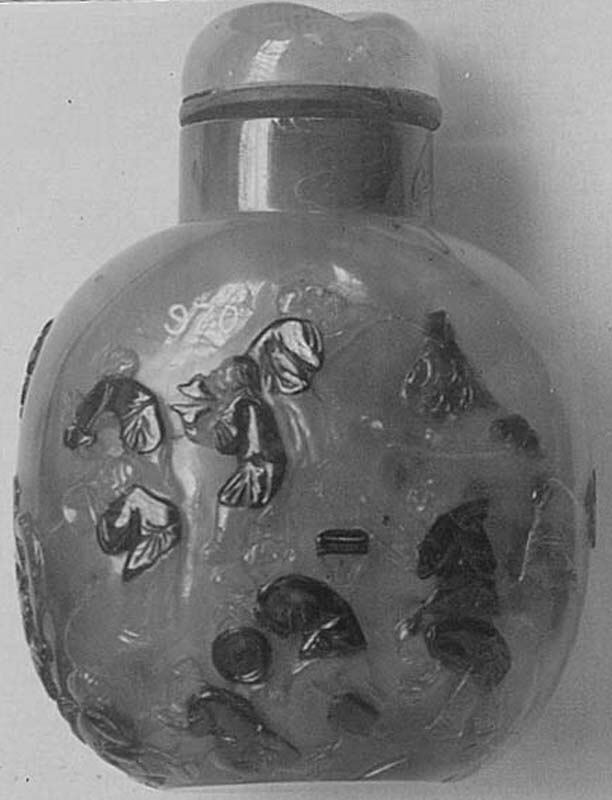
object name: snuff bottle with stopper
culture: chinese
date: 1701-1900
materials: stone, quartz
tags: human figures